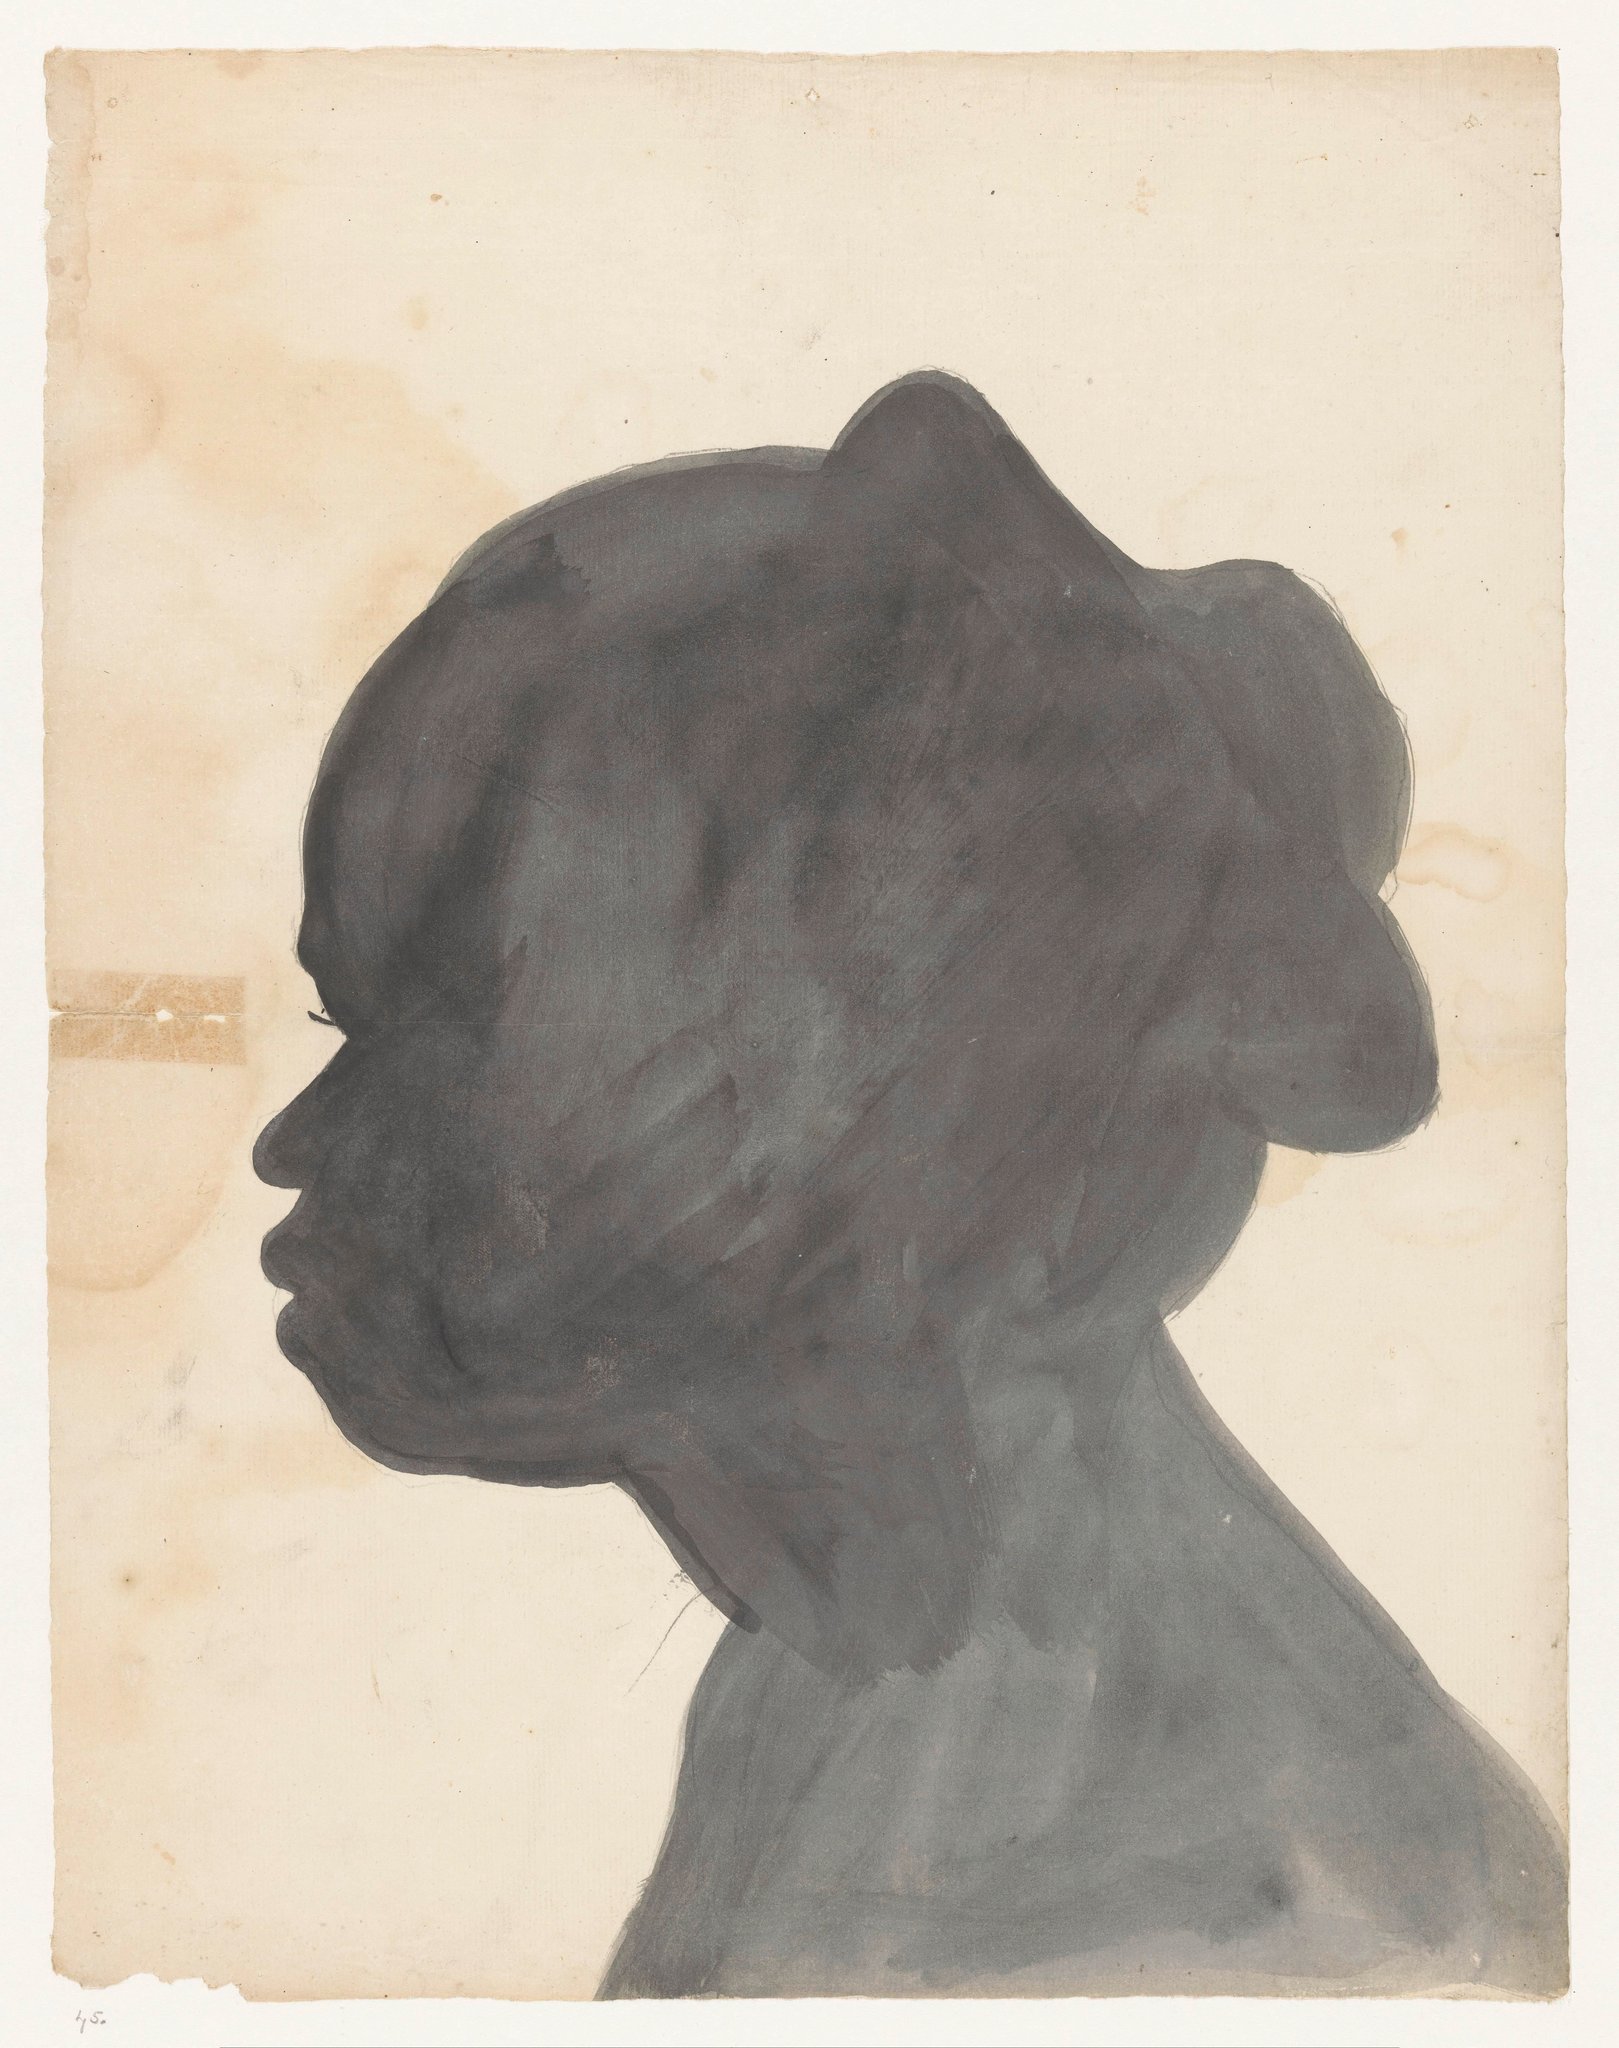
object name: drawing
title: Silhouetportret van Sara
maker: jan brandes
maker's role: draughtsman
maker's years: 1743-1808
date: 1783-1784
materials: ink, paper, pencil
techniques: brush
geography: batavia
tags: slavery; serfs and enslaved persons, batavia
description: Portret in silhouet van Sara, een tot slaaf gemaakte vrouw uit de huishouding van de tekenaar Jan Brandes.